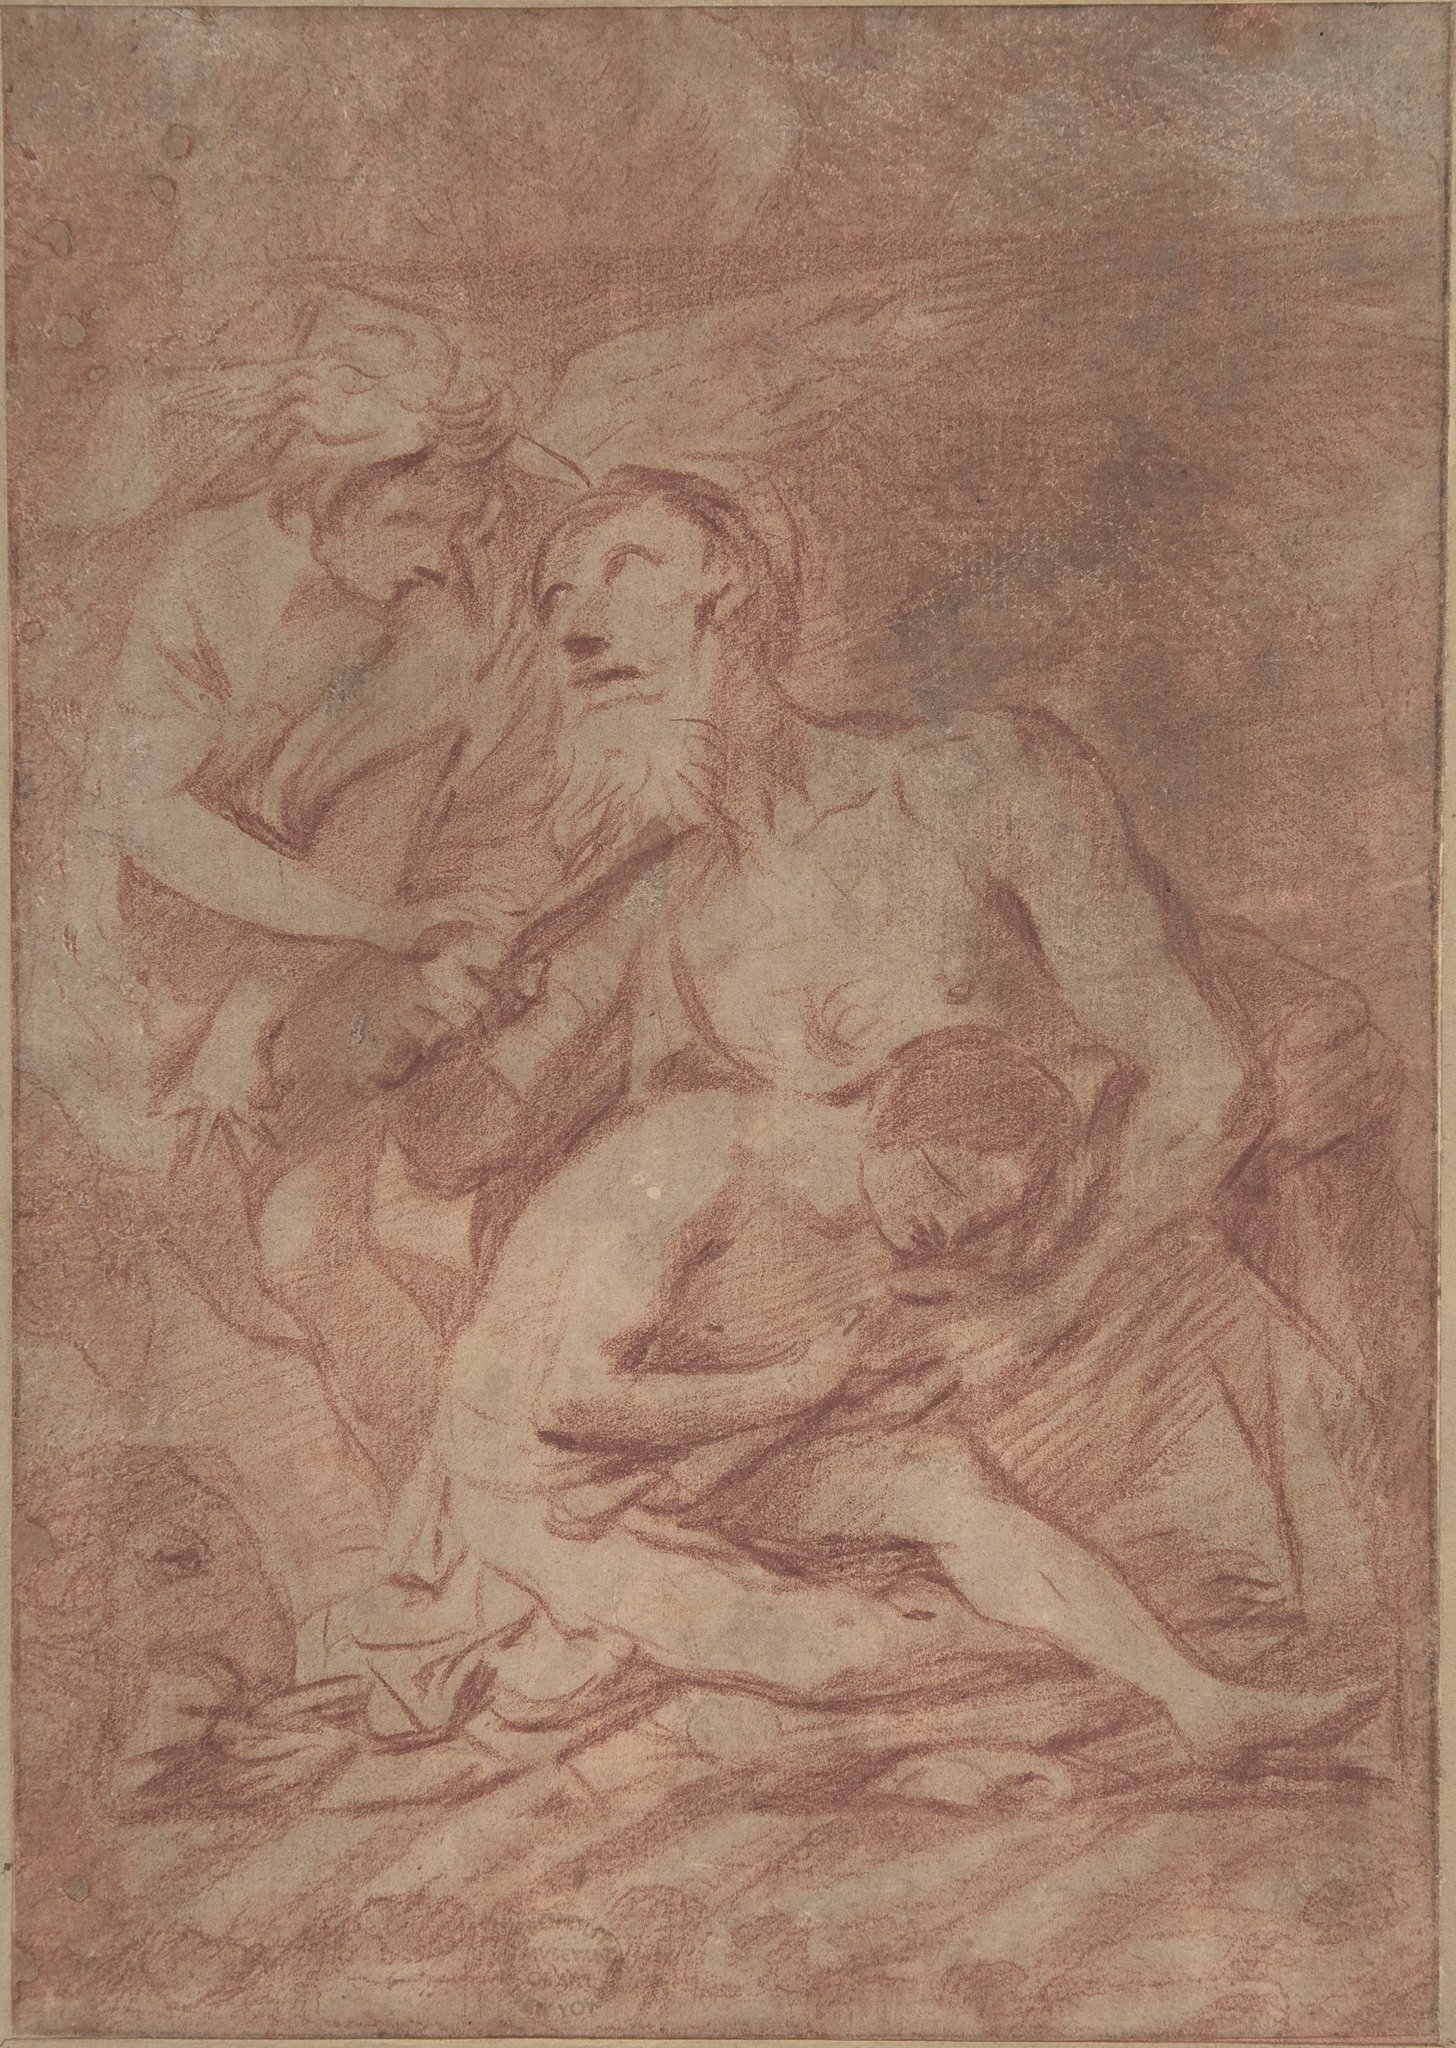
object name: drawing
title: Sacrifice of Isaac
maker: anonymous, italian, roman-bolognese, 17th century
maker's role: artist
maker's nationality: italian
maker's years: 1600-1700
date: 1601-1700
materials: chalk, paper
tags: men